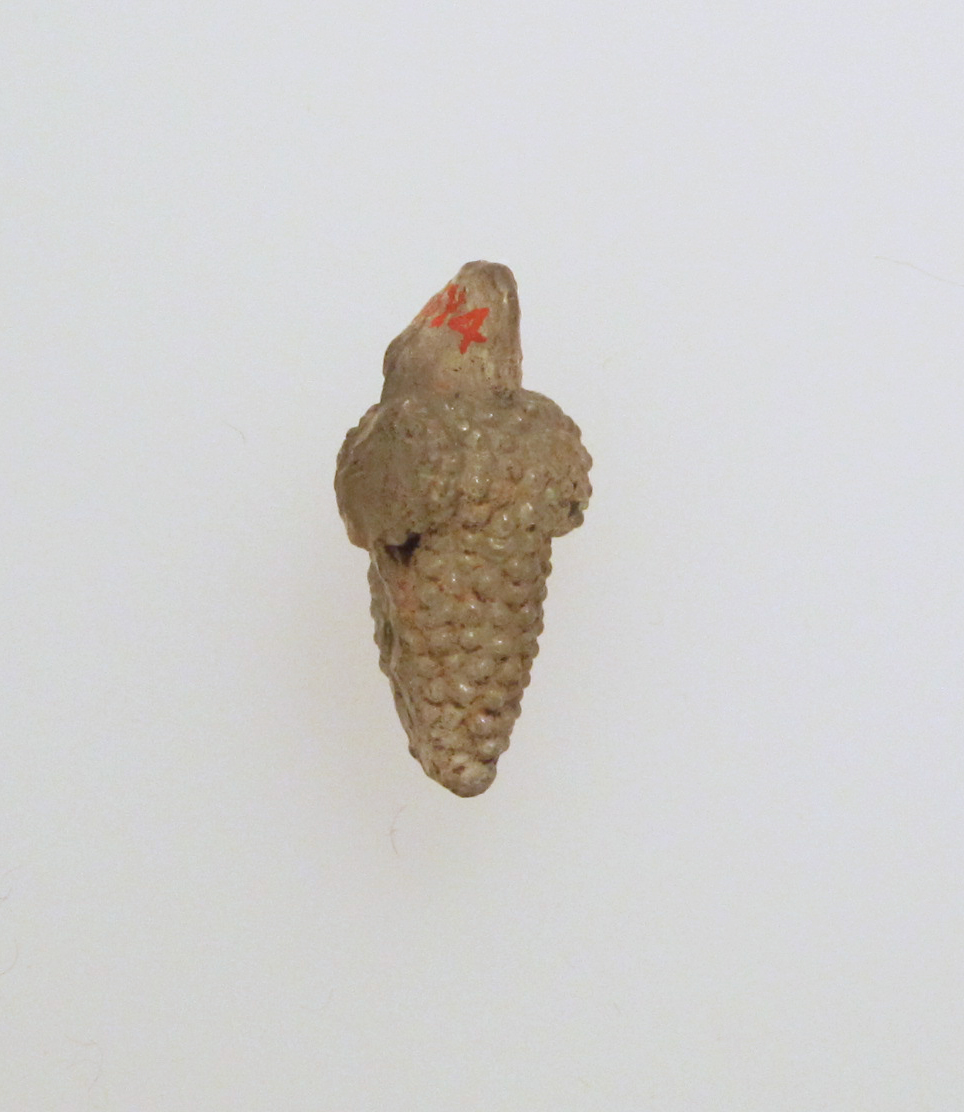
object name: pendant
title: Glass pendant in the form of a bunch of grapes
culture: greek, eastern mediterranean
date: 134-1 BCE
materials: glass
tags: grapes